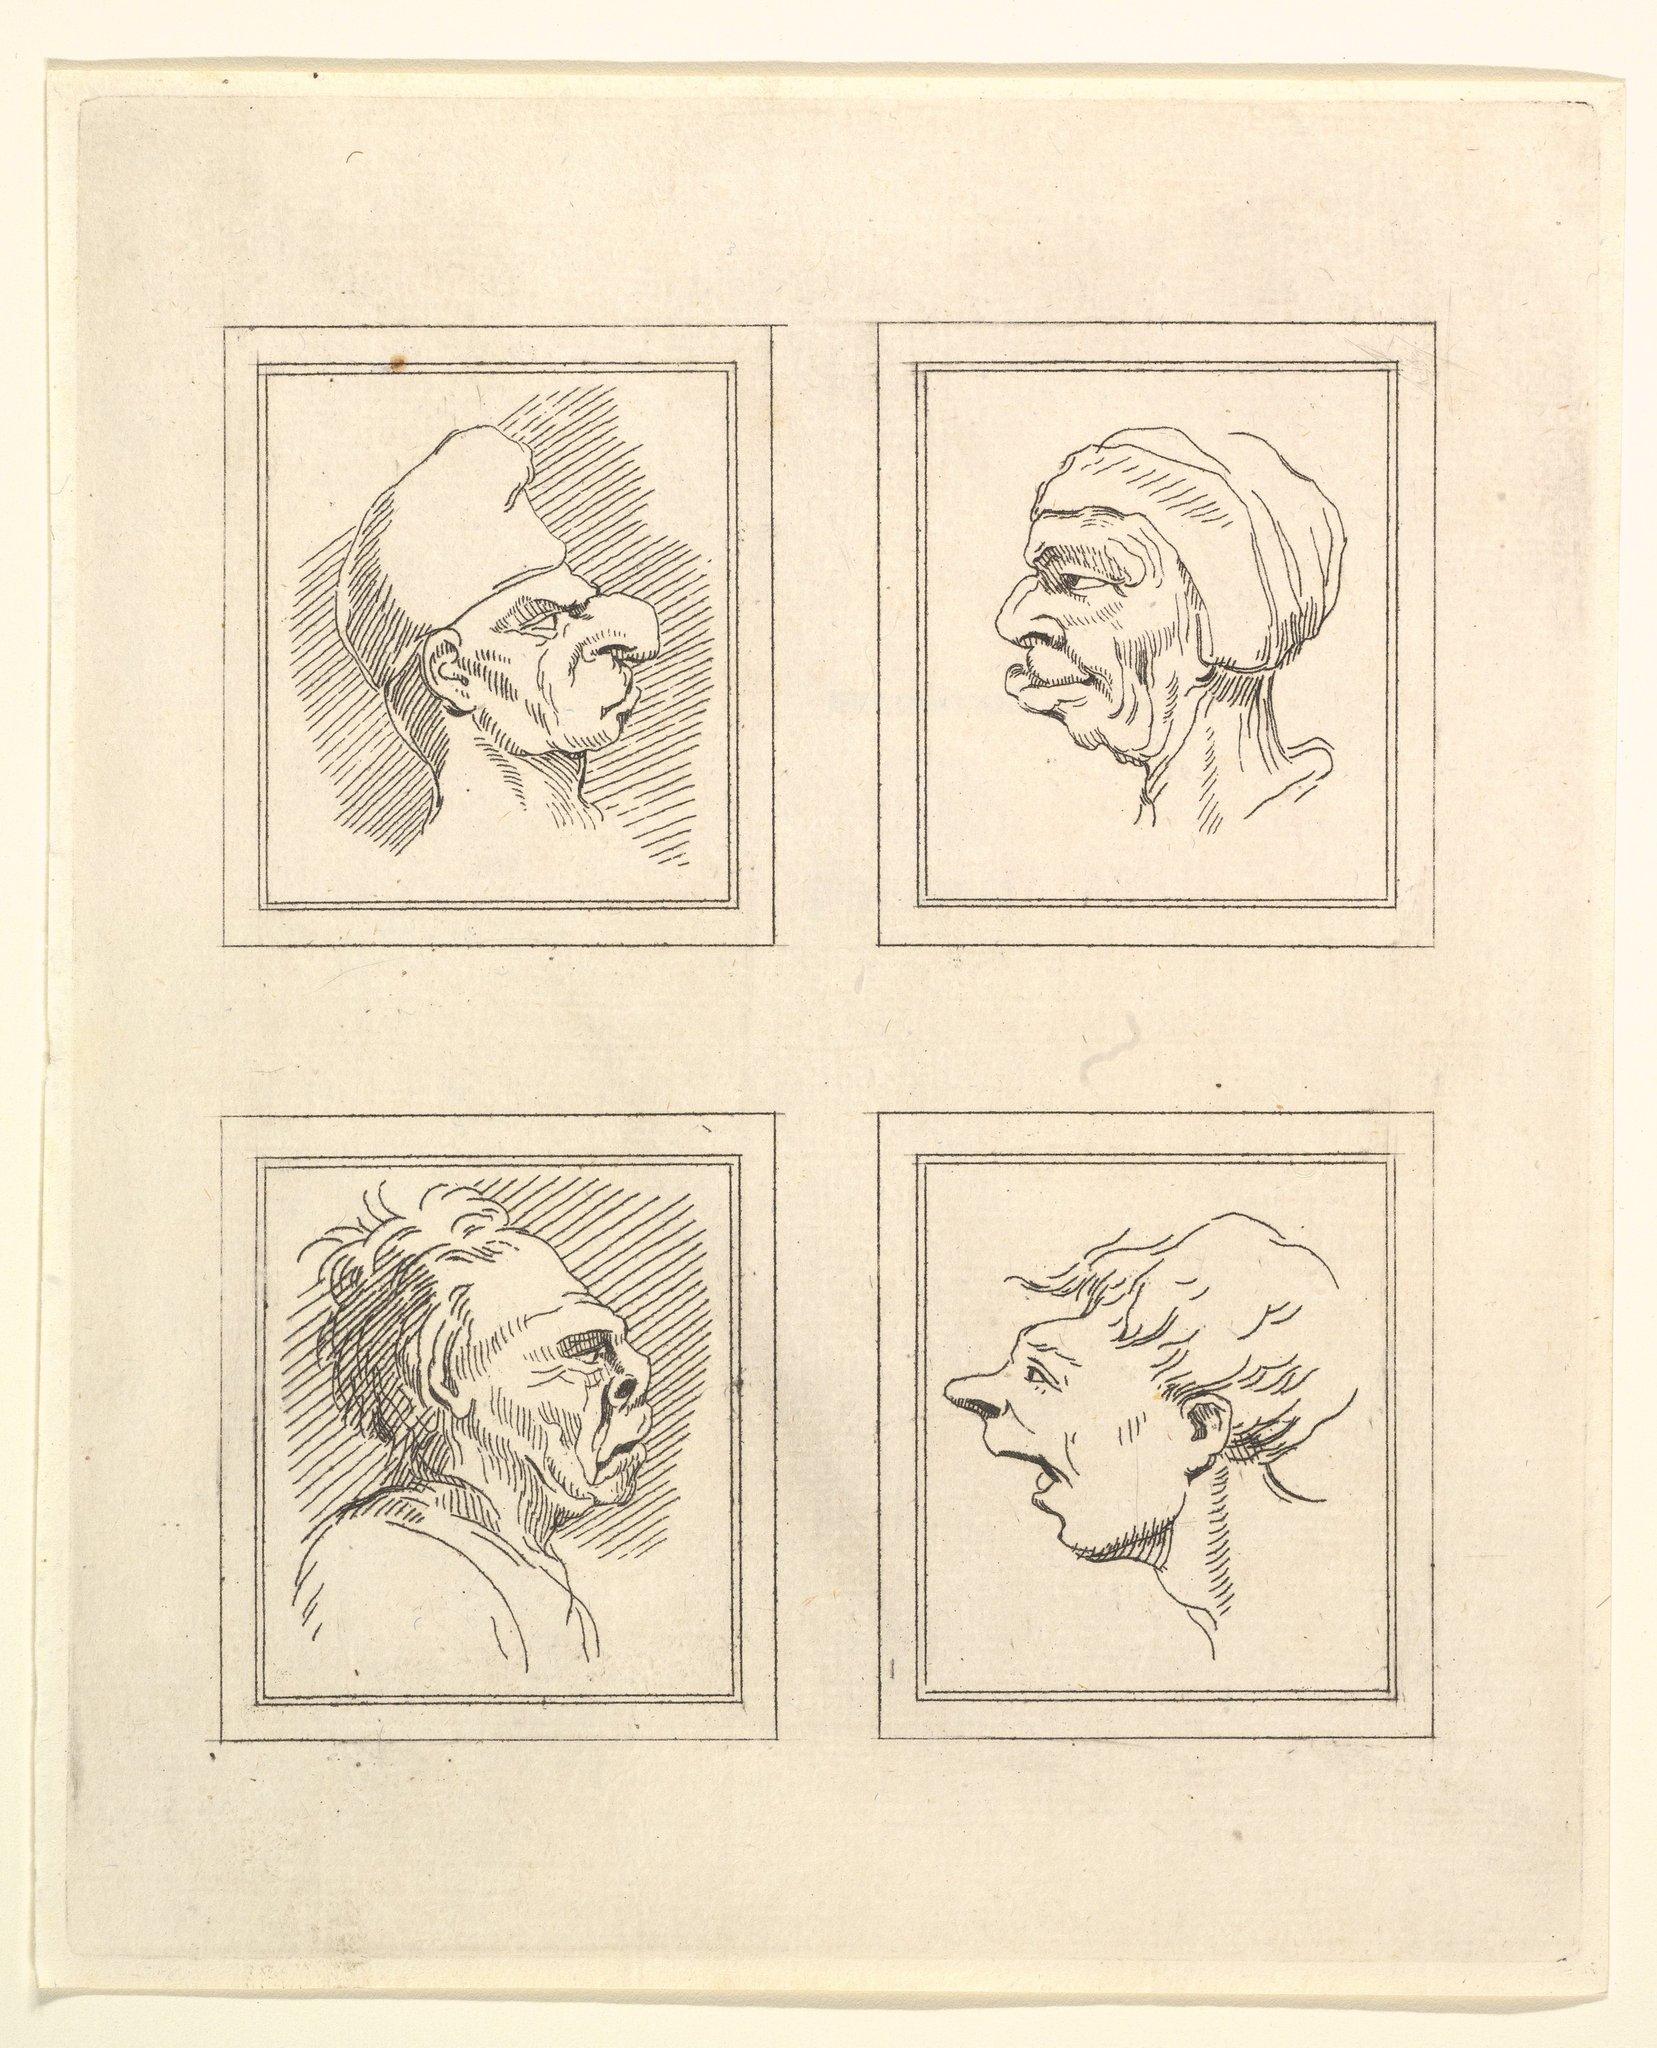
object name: print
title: Four Heads (from Characaturas by Leonardo da Vinci, from Drawings by Wenceslaus Hollar, out of the Portland Museum)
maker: wenceslaus hollar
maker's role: artist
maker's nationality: bohemian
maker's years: 1607-1677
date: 1786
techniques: etching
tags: human figures,heads